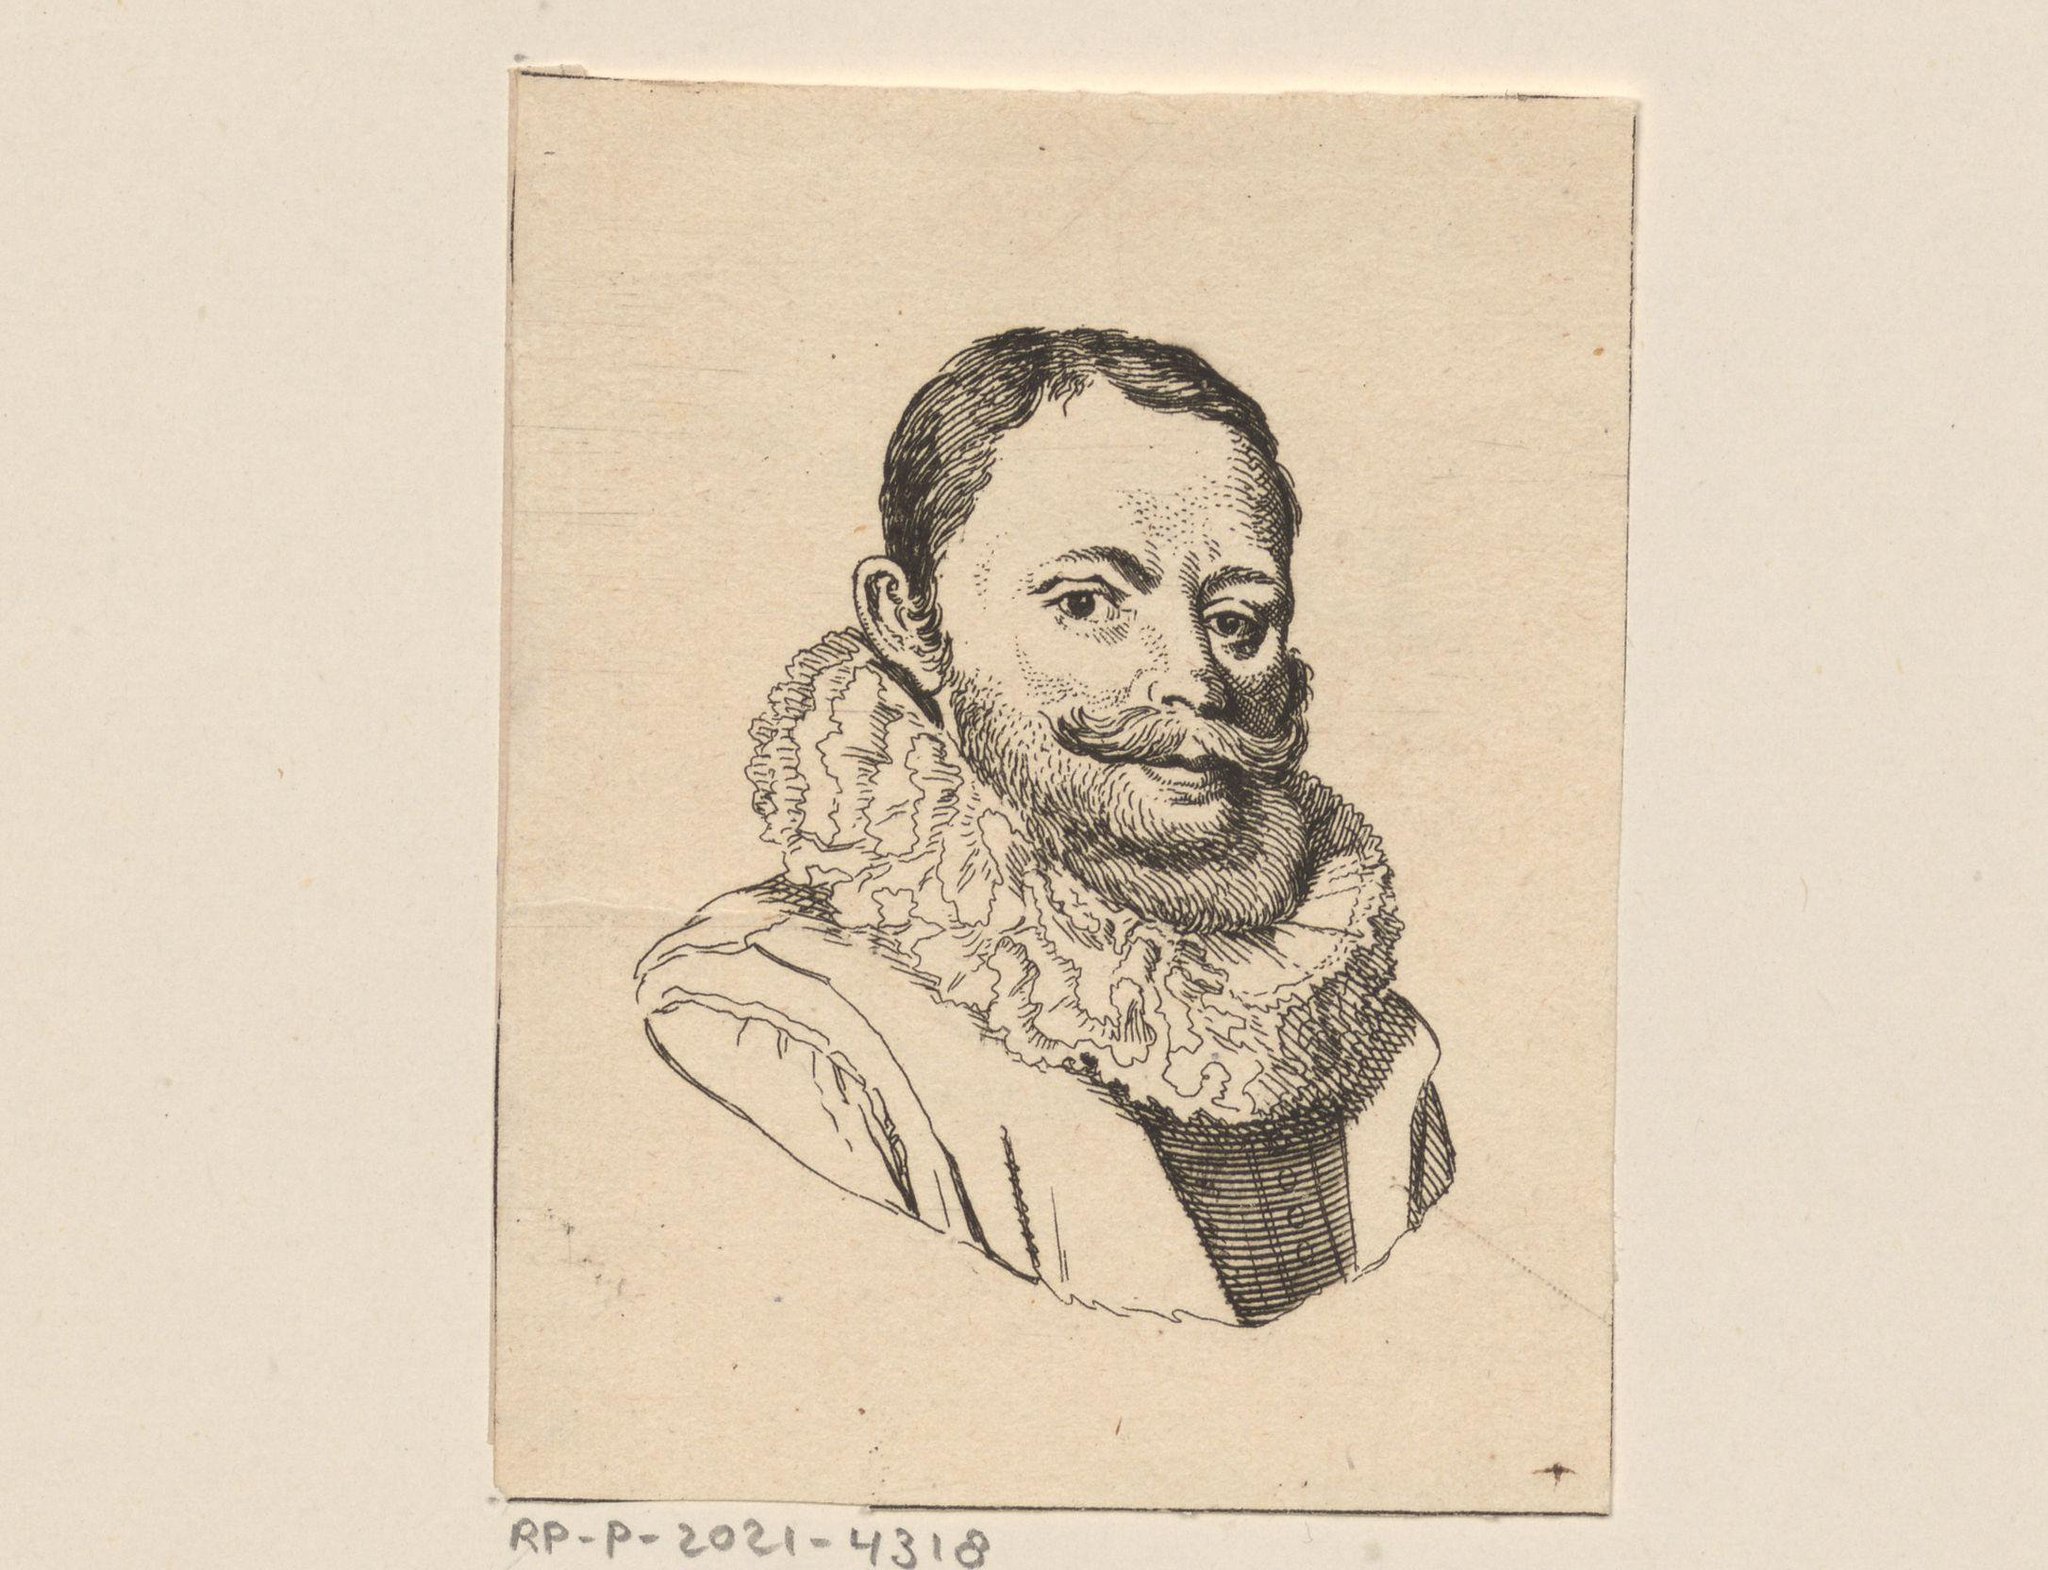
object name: print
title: Portret van Otto Heurnius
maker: Anonymous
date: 1600-1649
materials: paper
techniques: etching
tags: otto heurnius, historical persons, physician, doctor